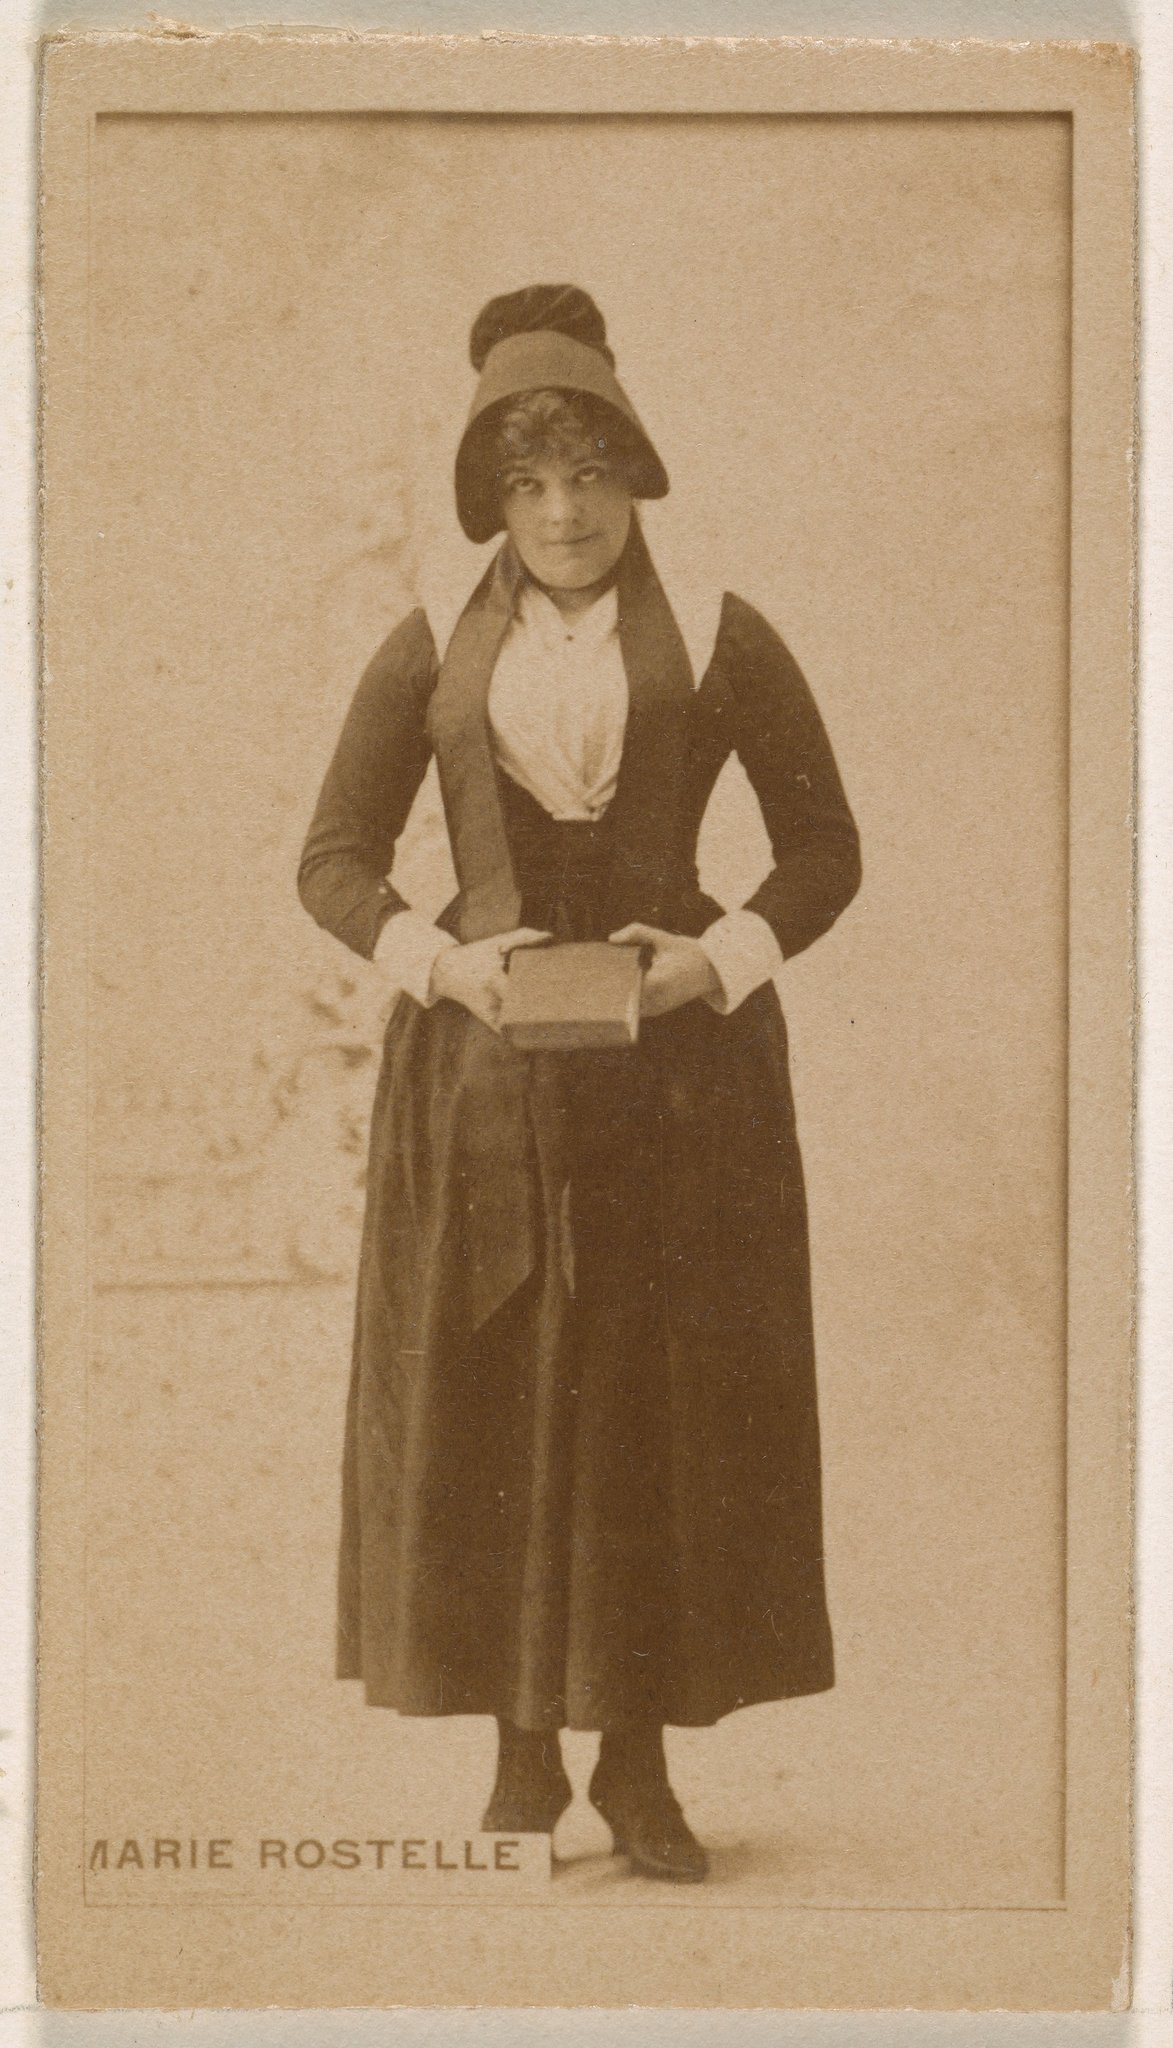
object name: photograph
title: Marie Rostelle, from the Actresses series (N245) issued by Kinney Brothers to promote Sweet Caporal Cigarettes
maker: kinney brothers tobacco company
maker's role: publisher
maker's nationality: american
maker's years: 1869-2011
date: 1890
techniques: albumen silver print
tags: portraits,women,actresses